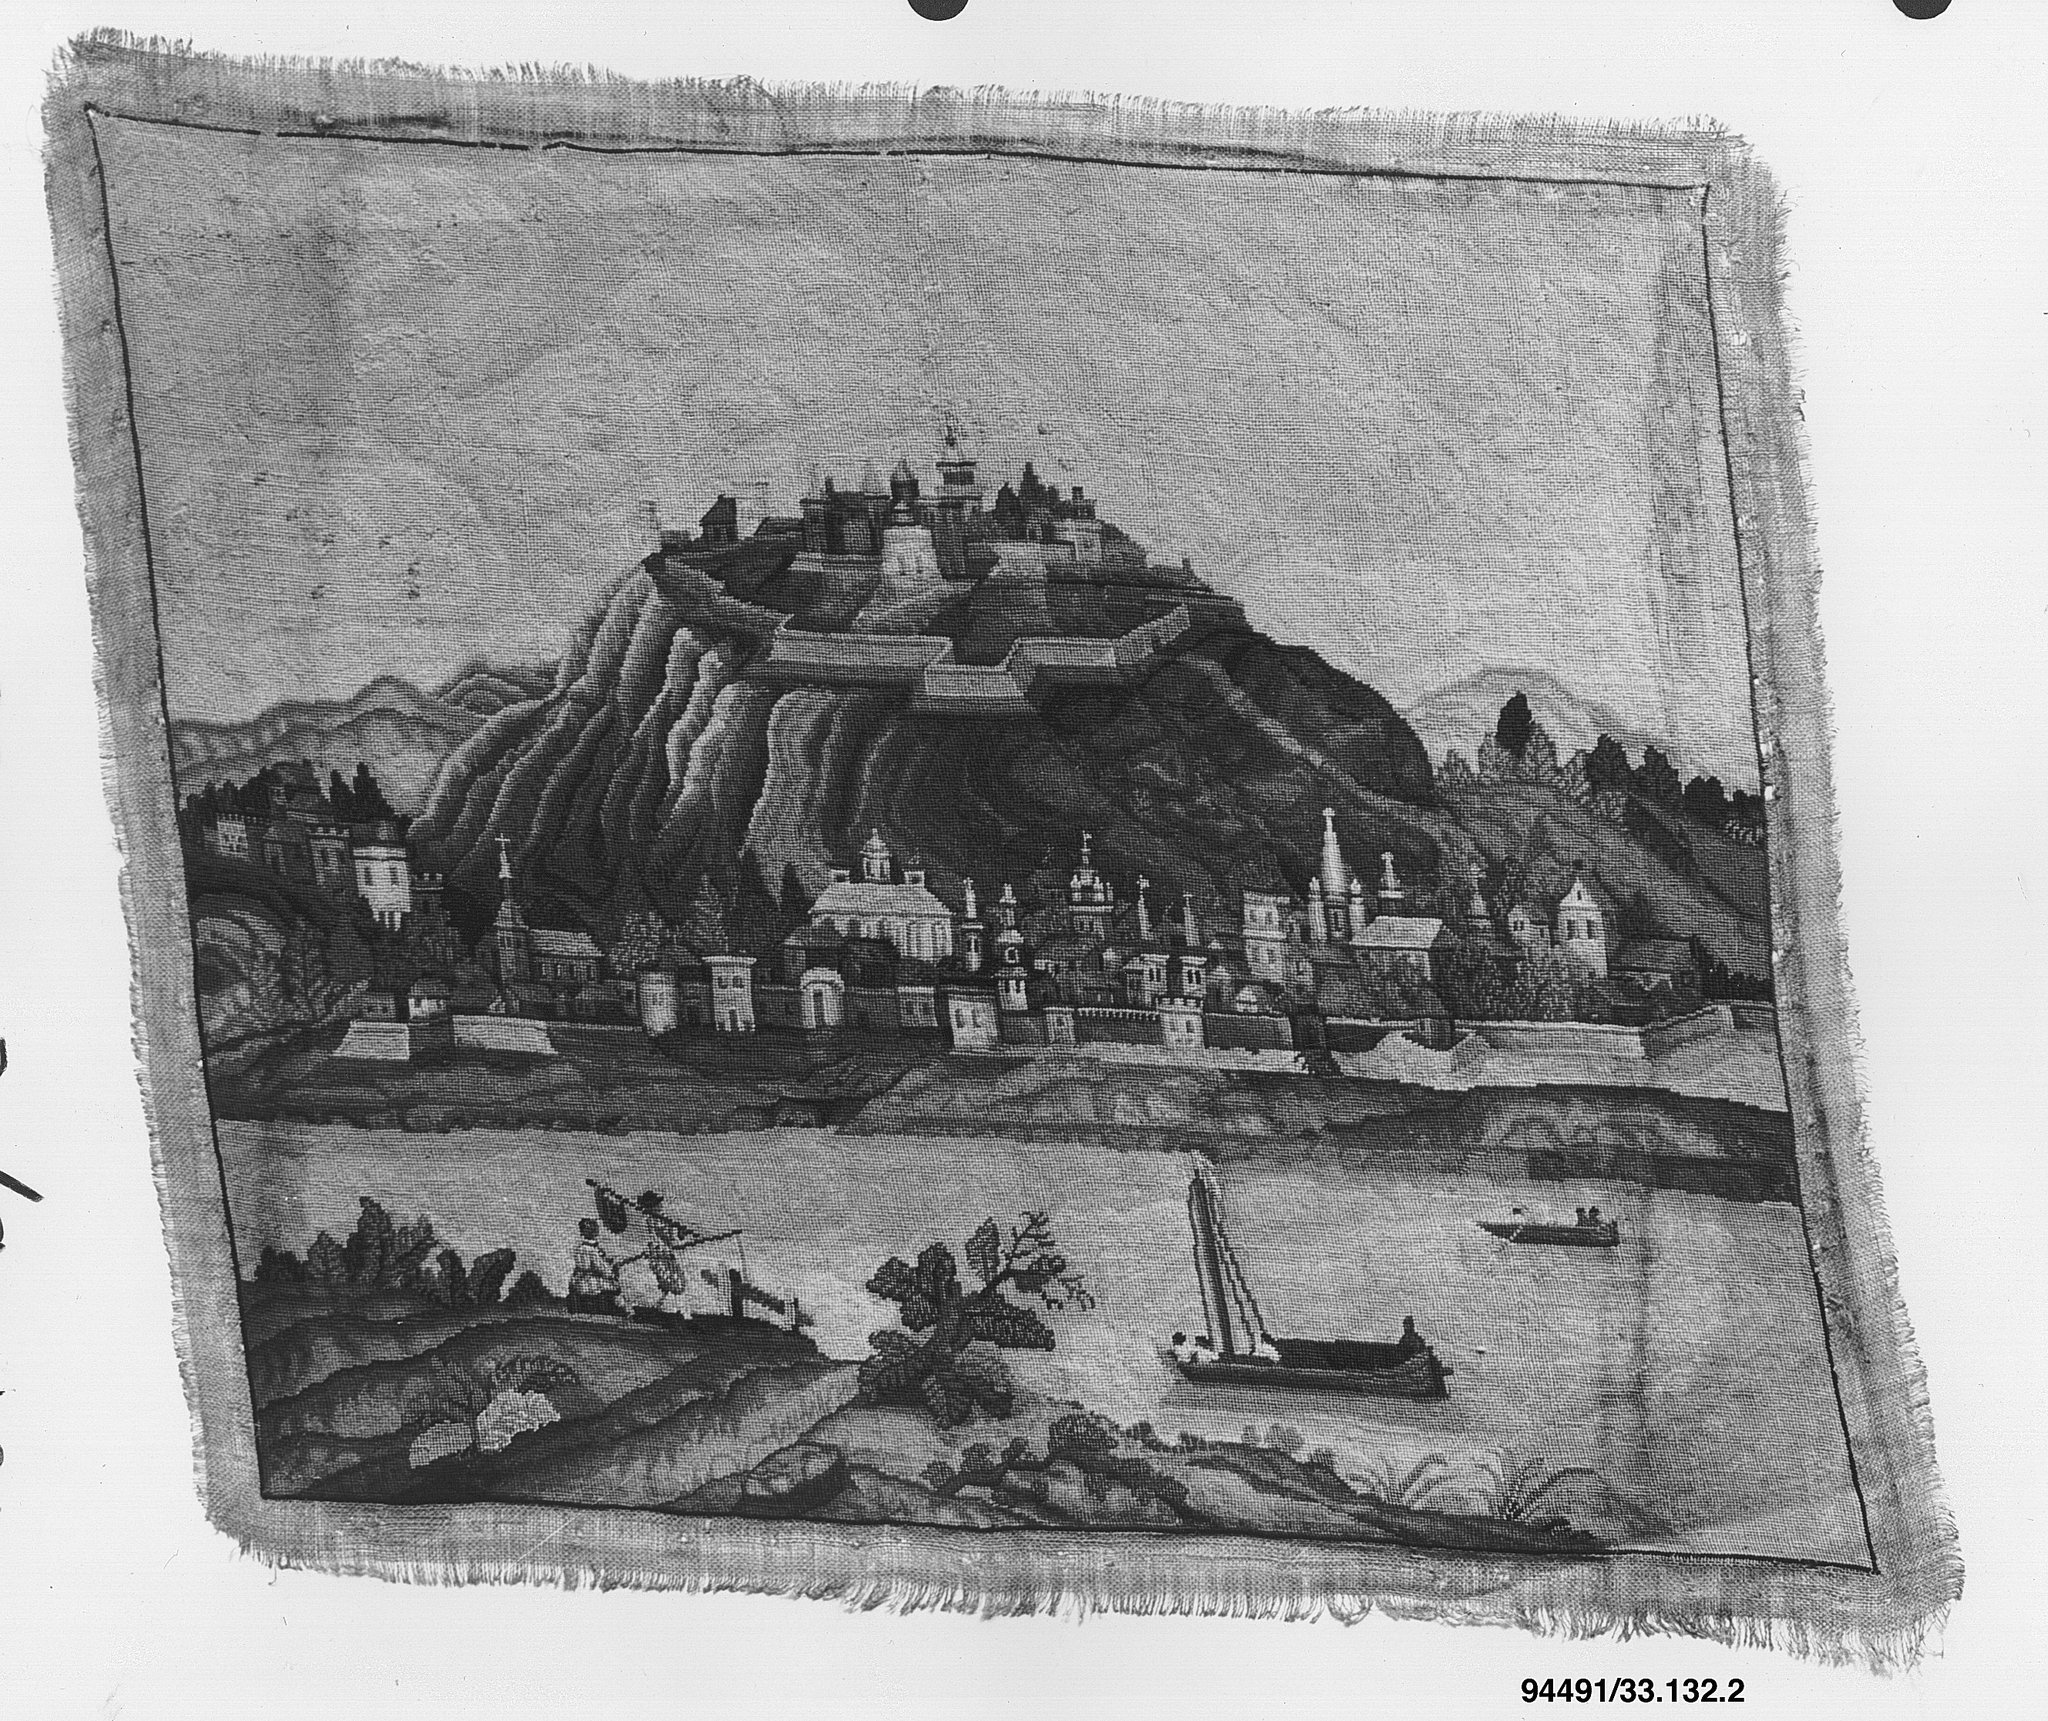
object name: panel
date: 1701-1800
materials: silk, wool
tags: castles,fishing,landscapes,boats